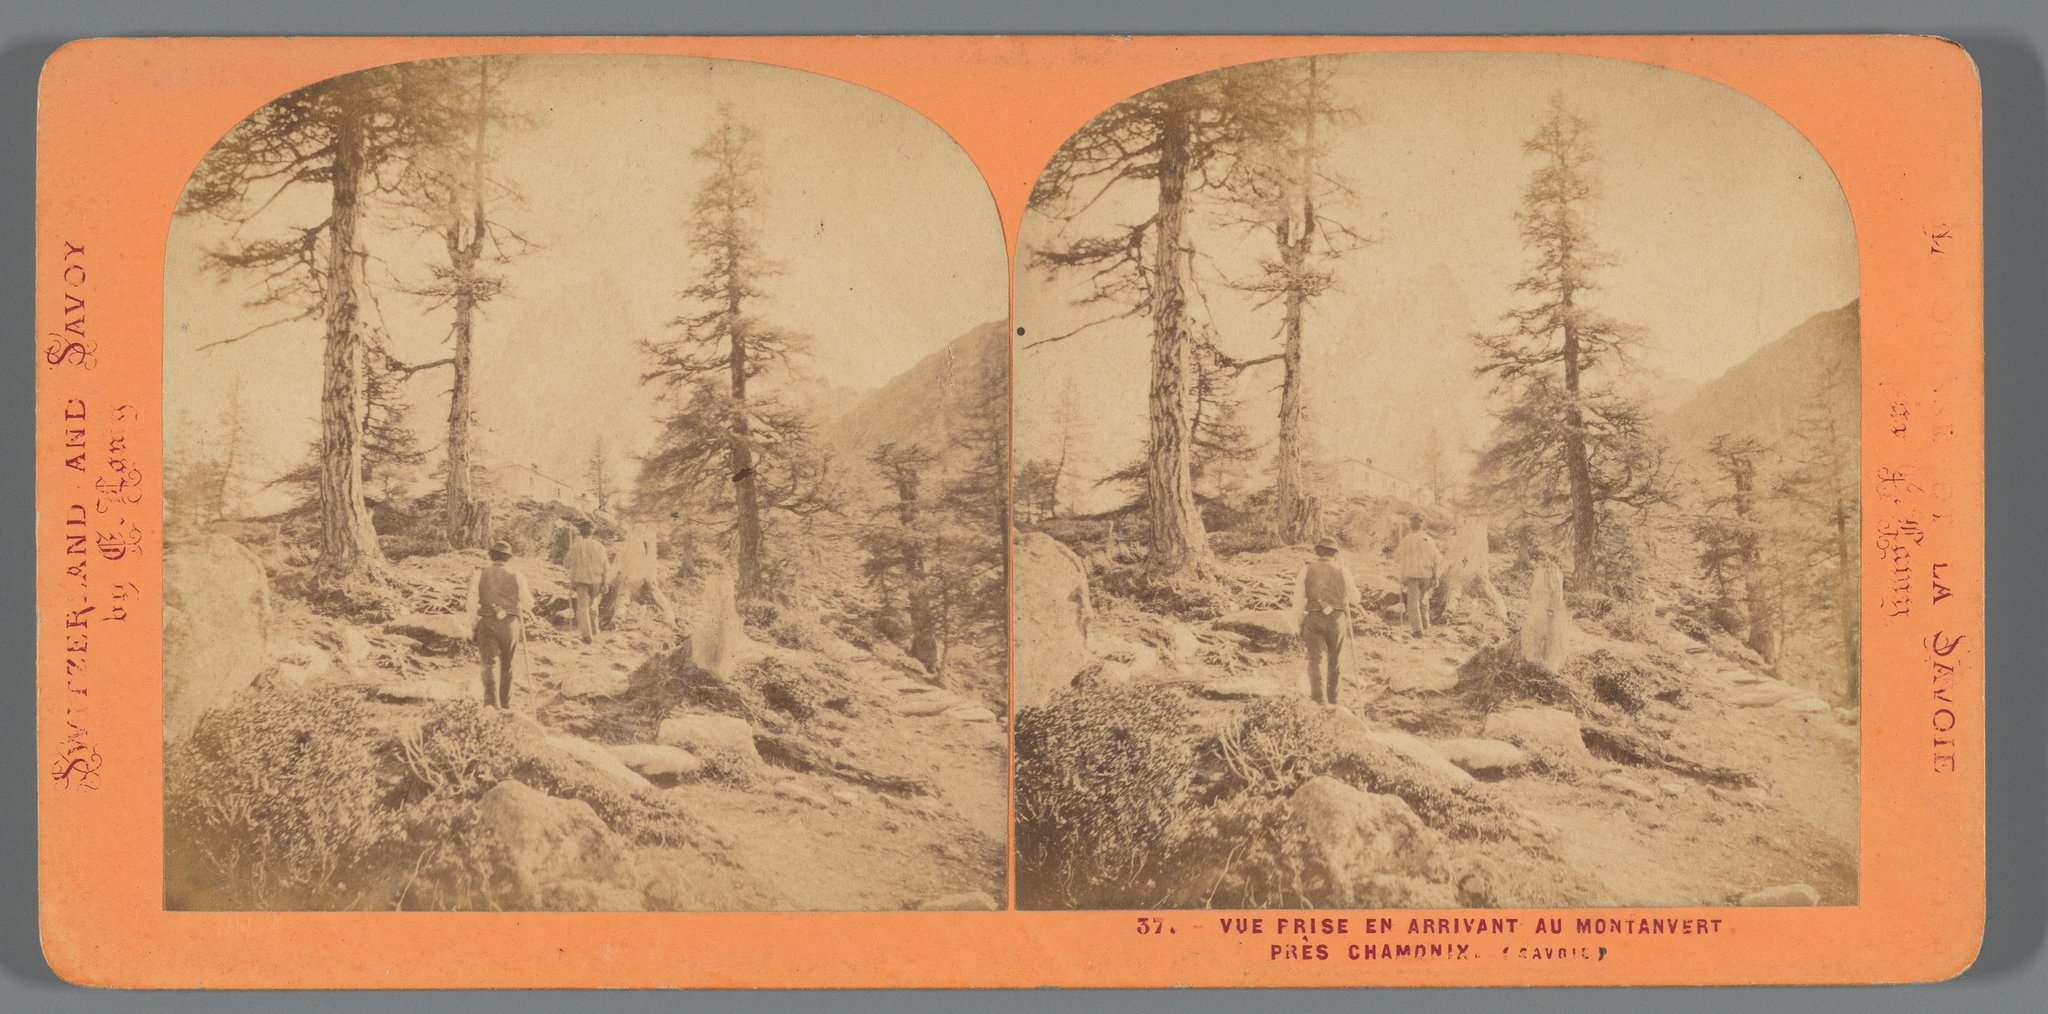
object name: stereograph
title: Wandelaars bij Montenvers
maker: ernest eléonor pierre lamy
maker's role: publisher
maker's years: 1828-1900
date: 1868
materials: cardboard, paper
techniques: albumen print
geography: montenvers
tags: walking, hiking (recreation)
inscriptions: number: ‘37.’